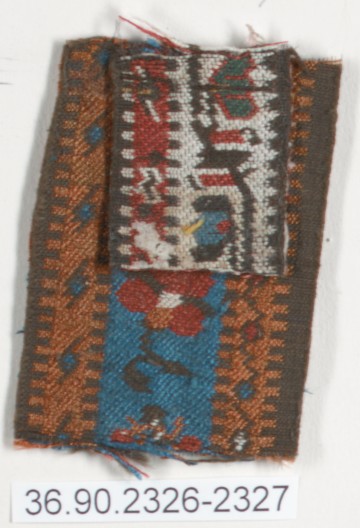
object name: border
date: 1801-1900